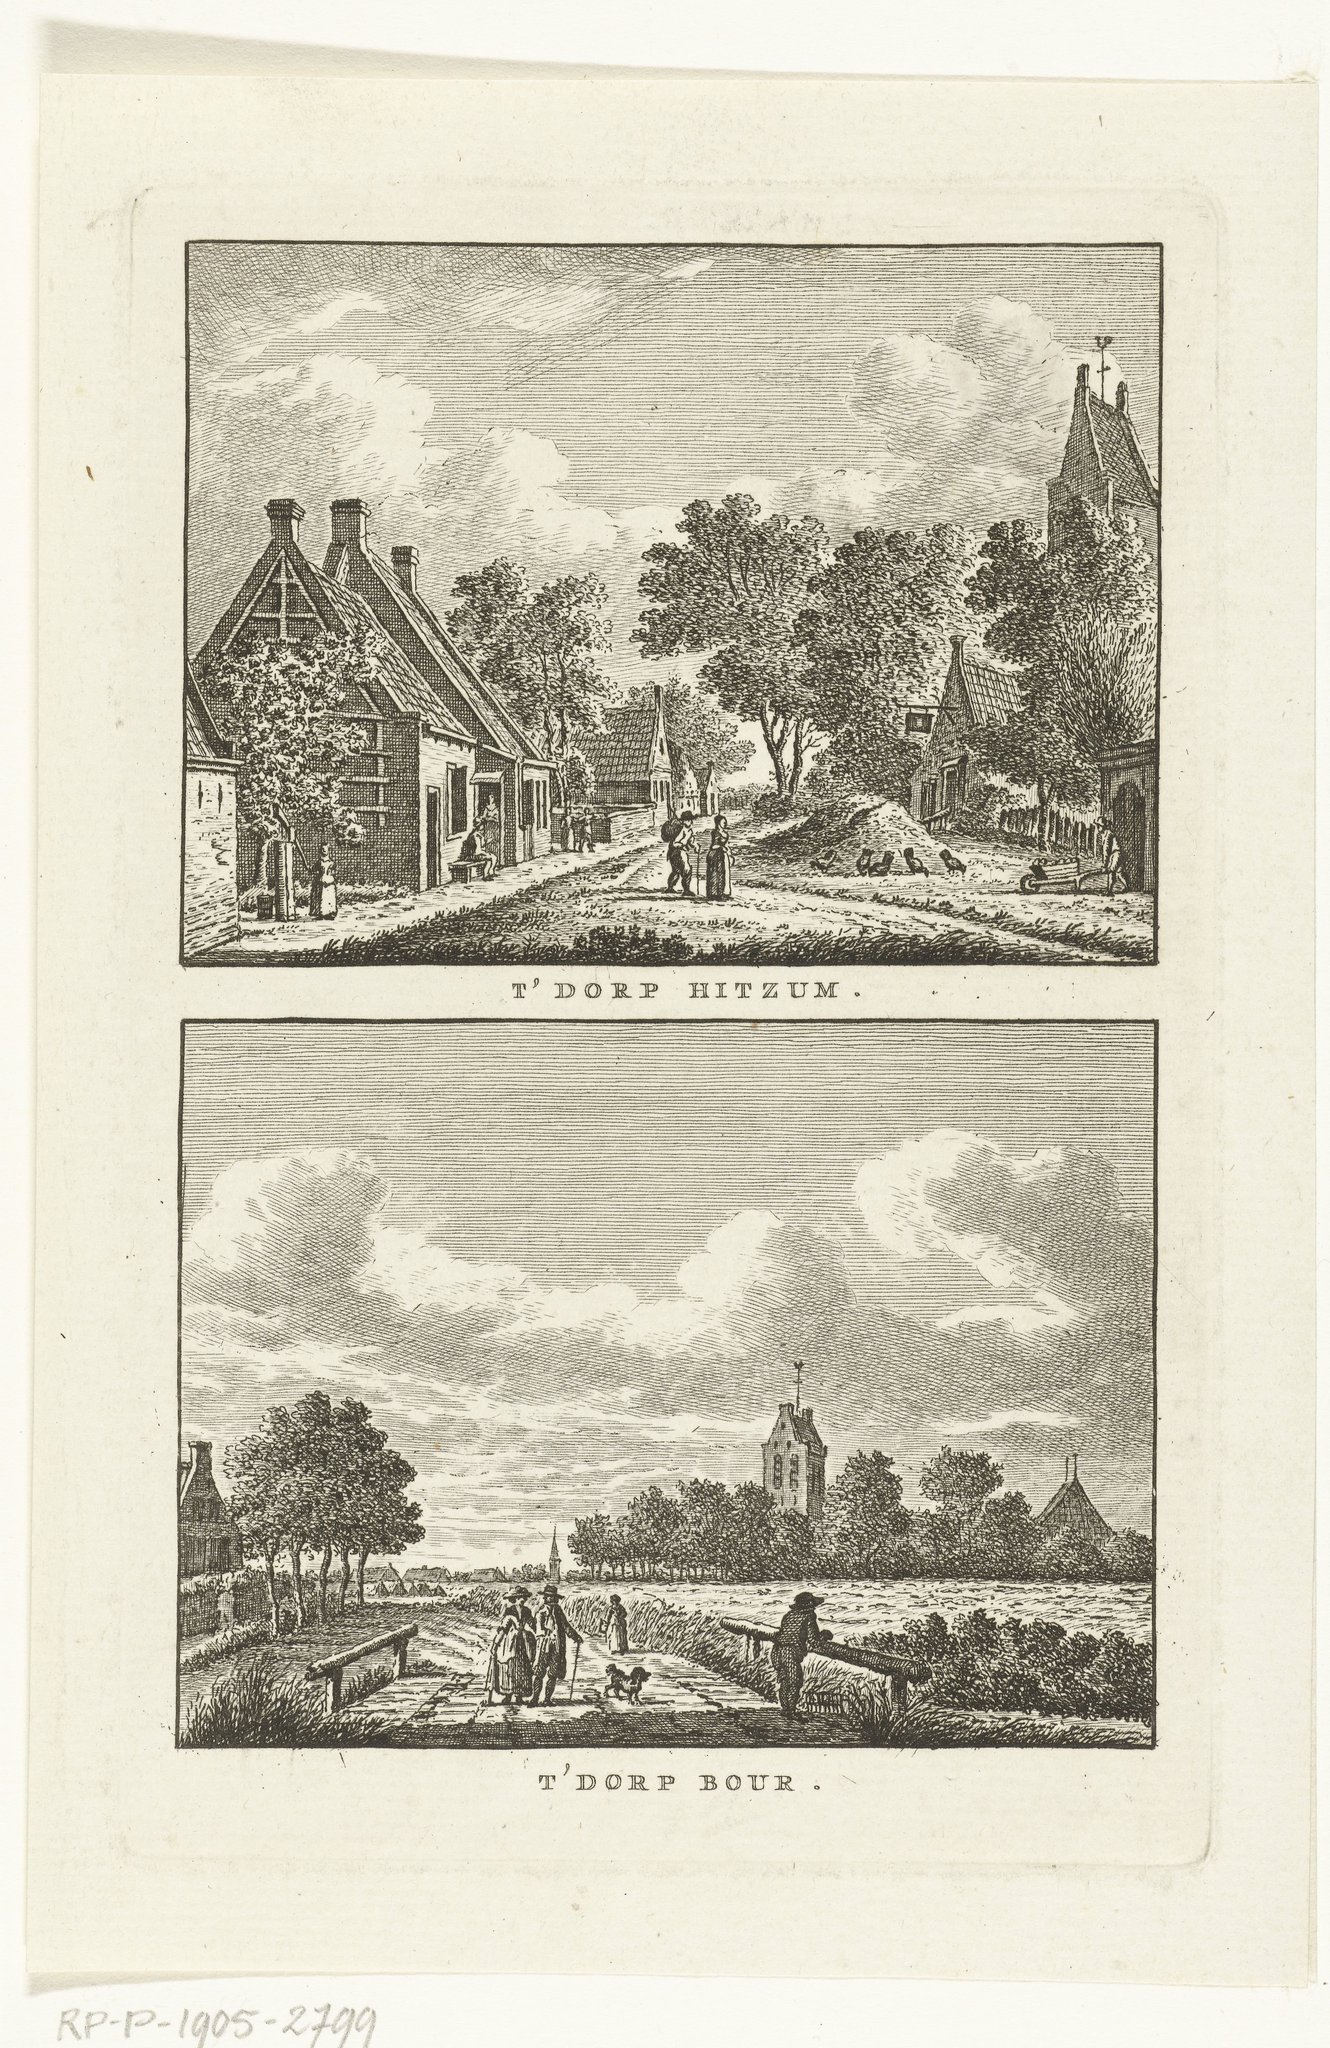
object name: print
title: T' dorp Hitzum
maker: carel frederik bendorp (i)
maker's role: print maker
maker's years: 1736-1814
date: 1786-1792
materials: paper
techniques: etching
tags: prospect of village, silhouette of village, village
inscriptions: collector's mark: Lugt 2228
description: Prent uit: Vaderlandsche gezichten, of afbeeldingen van den tegenwoordigen staat der Vereenigde Nederlanden (…). Amsterdam: Hendrik Gartman, Willem Vermandel en Jan Willem Smit, 1786-1792. Uitgegeven in afleveringen met ieder een eigen bifolium en inhoudsopgave. Alle prenten in deze publicatie zijn gegraveerd door Carel Frederik Bendorp (I) en, in de meeste gevallen, gebaseerd op tekeningen van Jan Bulthuis.